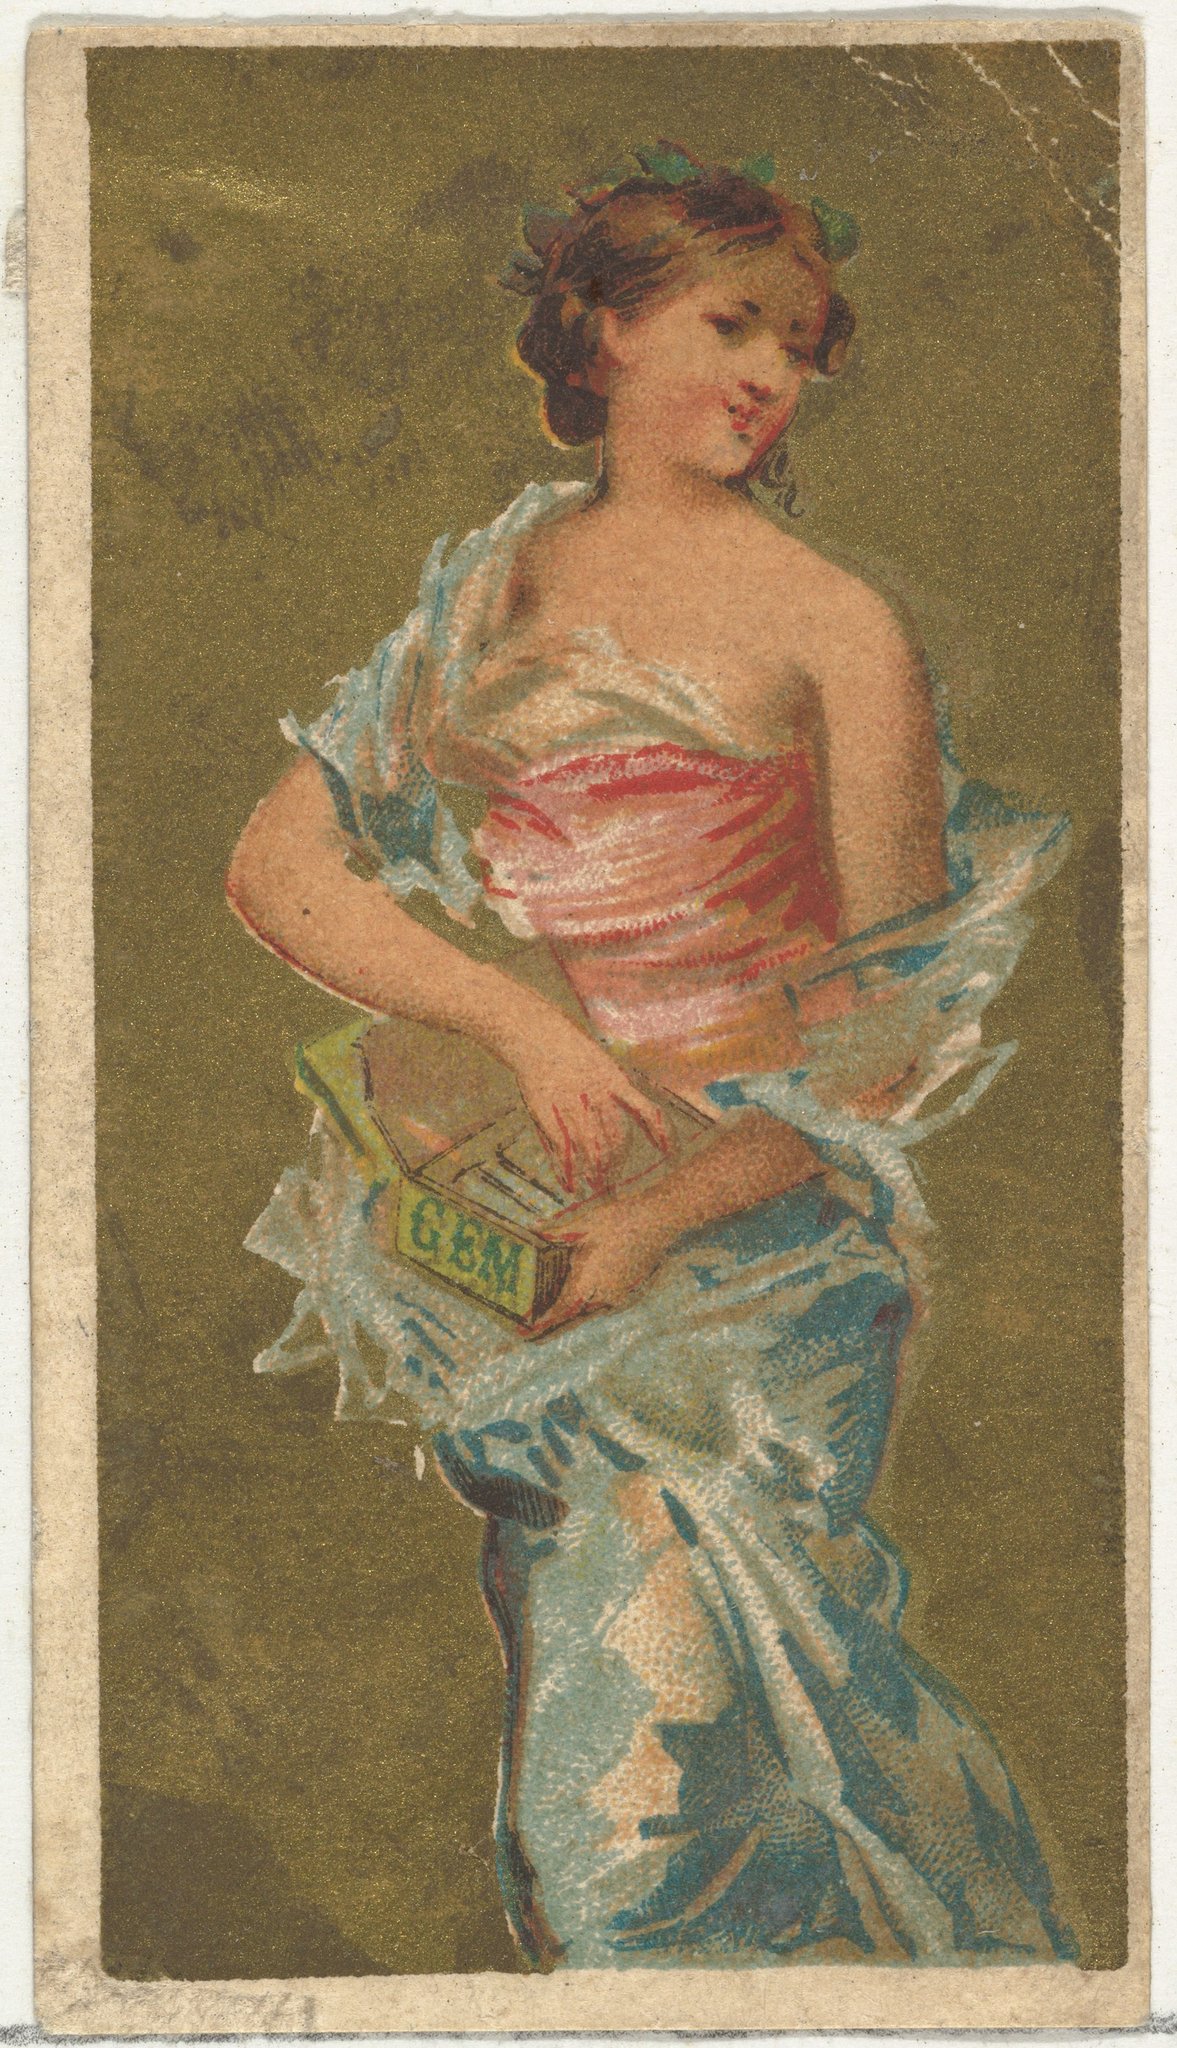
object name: print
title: From the Girls and Children series (N65) promoting Richmond Gem Cigarettes for Allen & Ginter brand tobacco products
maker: allen & ginter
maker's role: publisher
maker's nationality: american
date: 1886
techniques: color lithograph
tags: girls